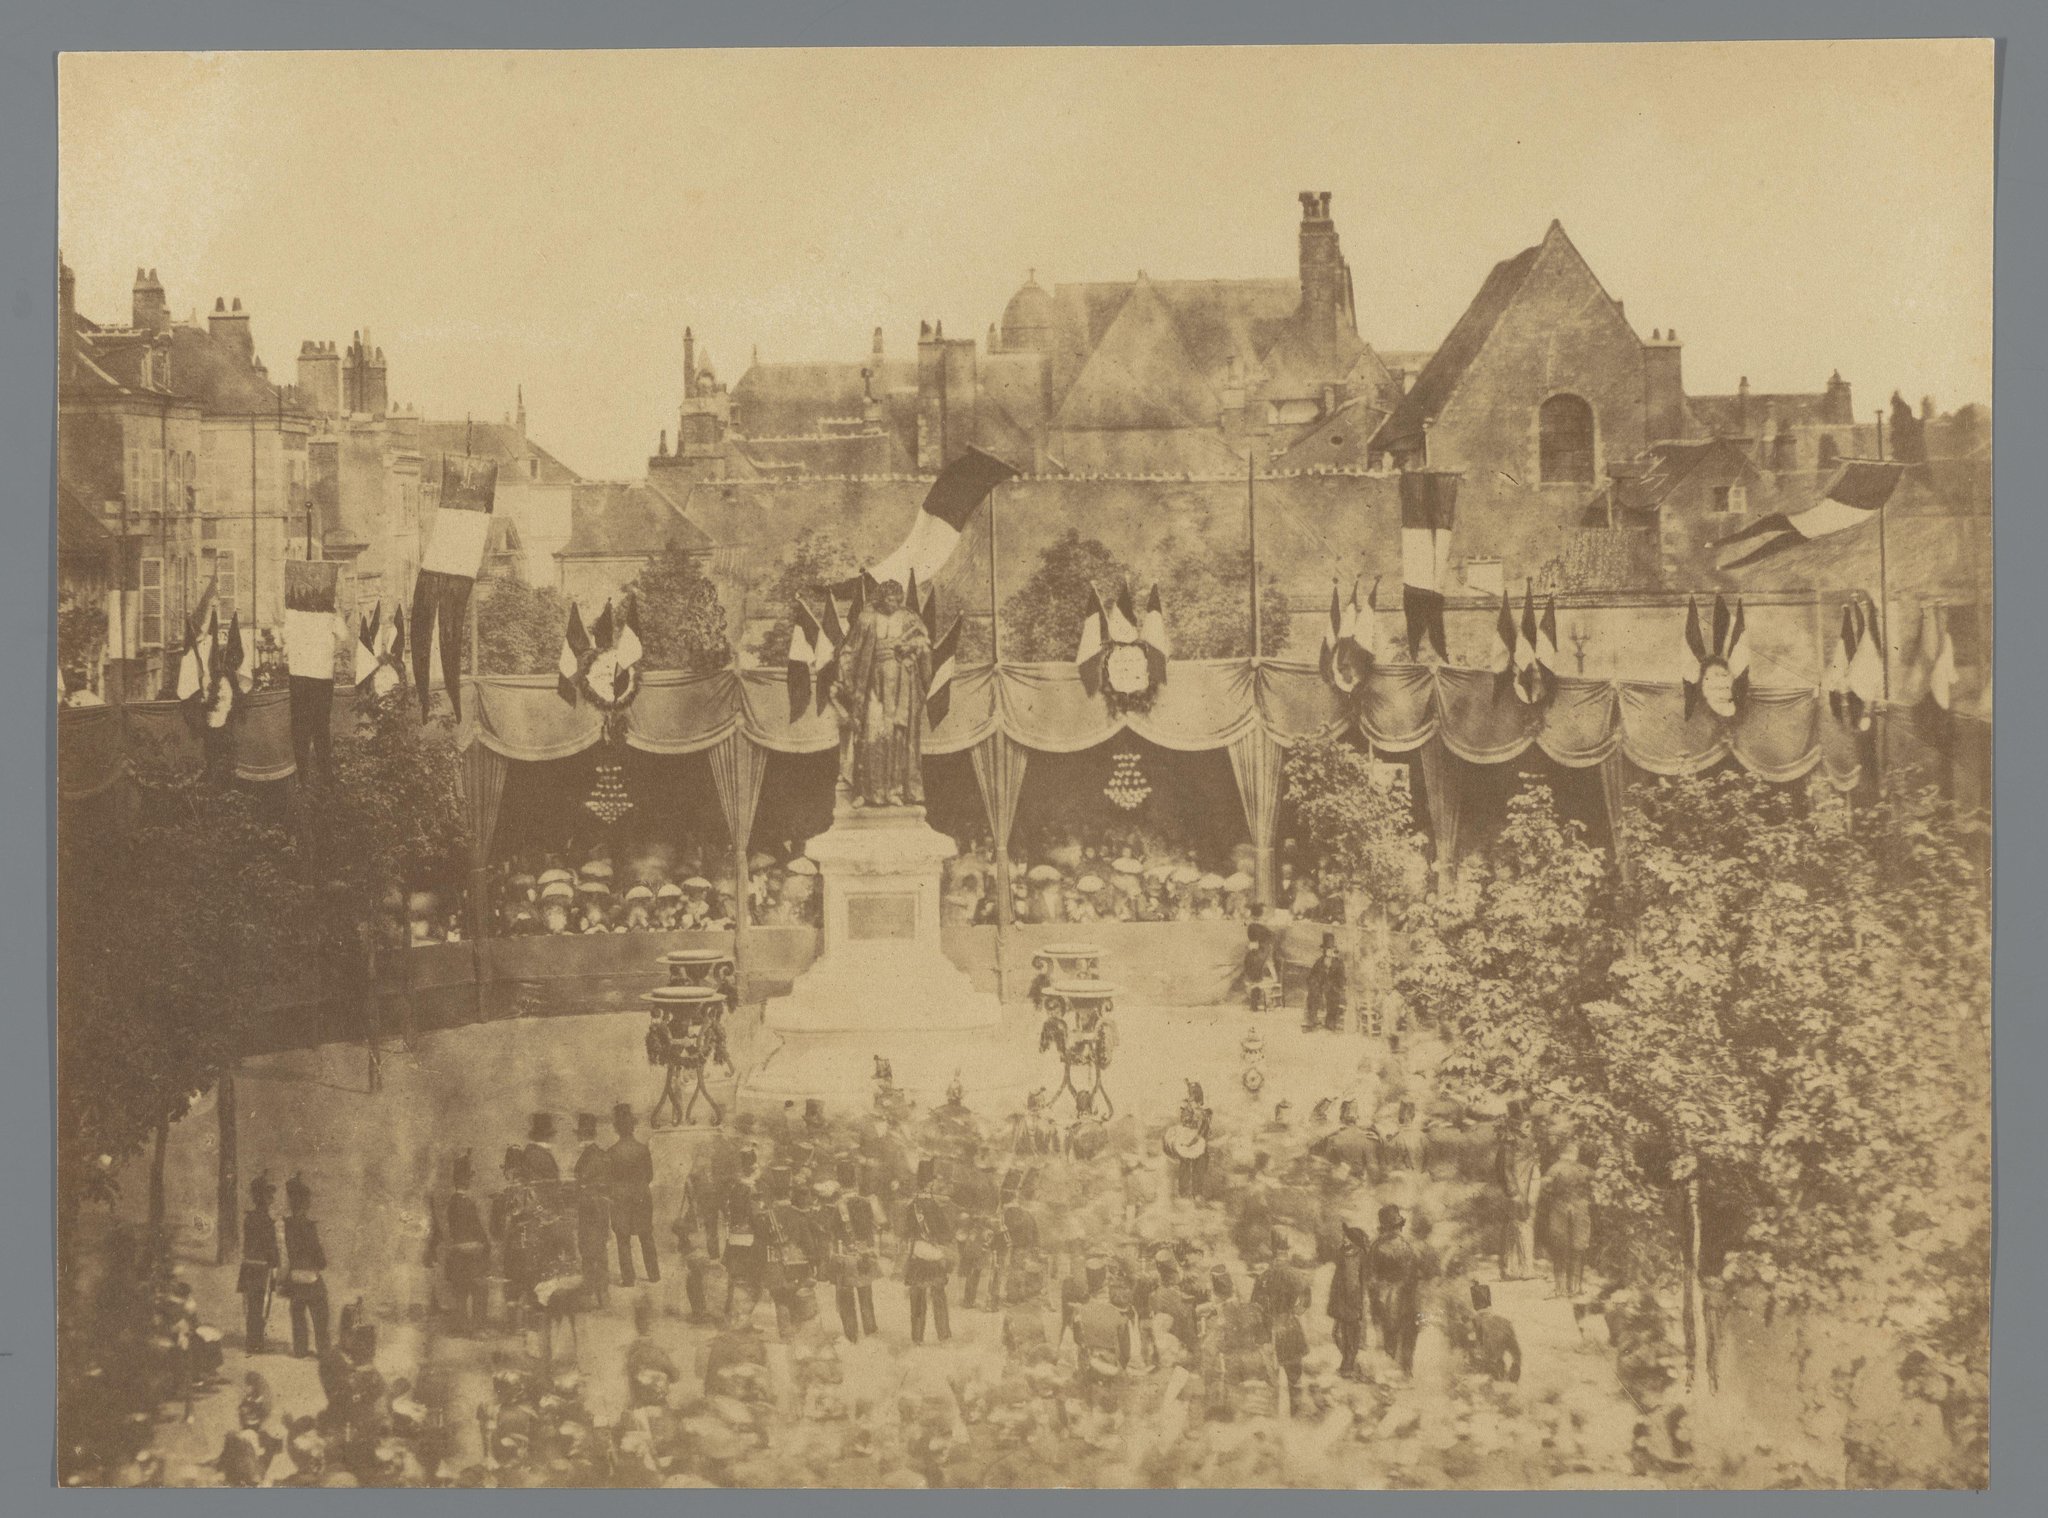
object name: photograph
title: Bezoek van koningin Victoria aan Parijs, augustus 1855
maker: andré-adolphe-eugène disdéri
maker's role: fotograaf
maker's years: 1819-1889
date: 1855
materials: paper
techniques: salted paper print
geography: paris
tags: victoria (koningin van het verenigd koninkrijk en keizerin van india), military parade, pageant, paris